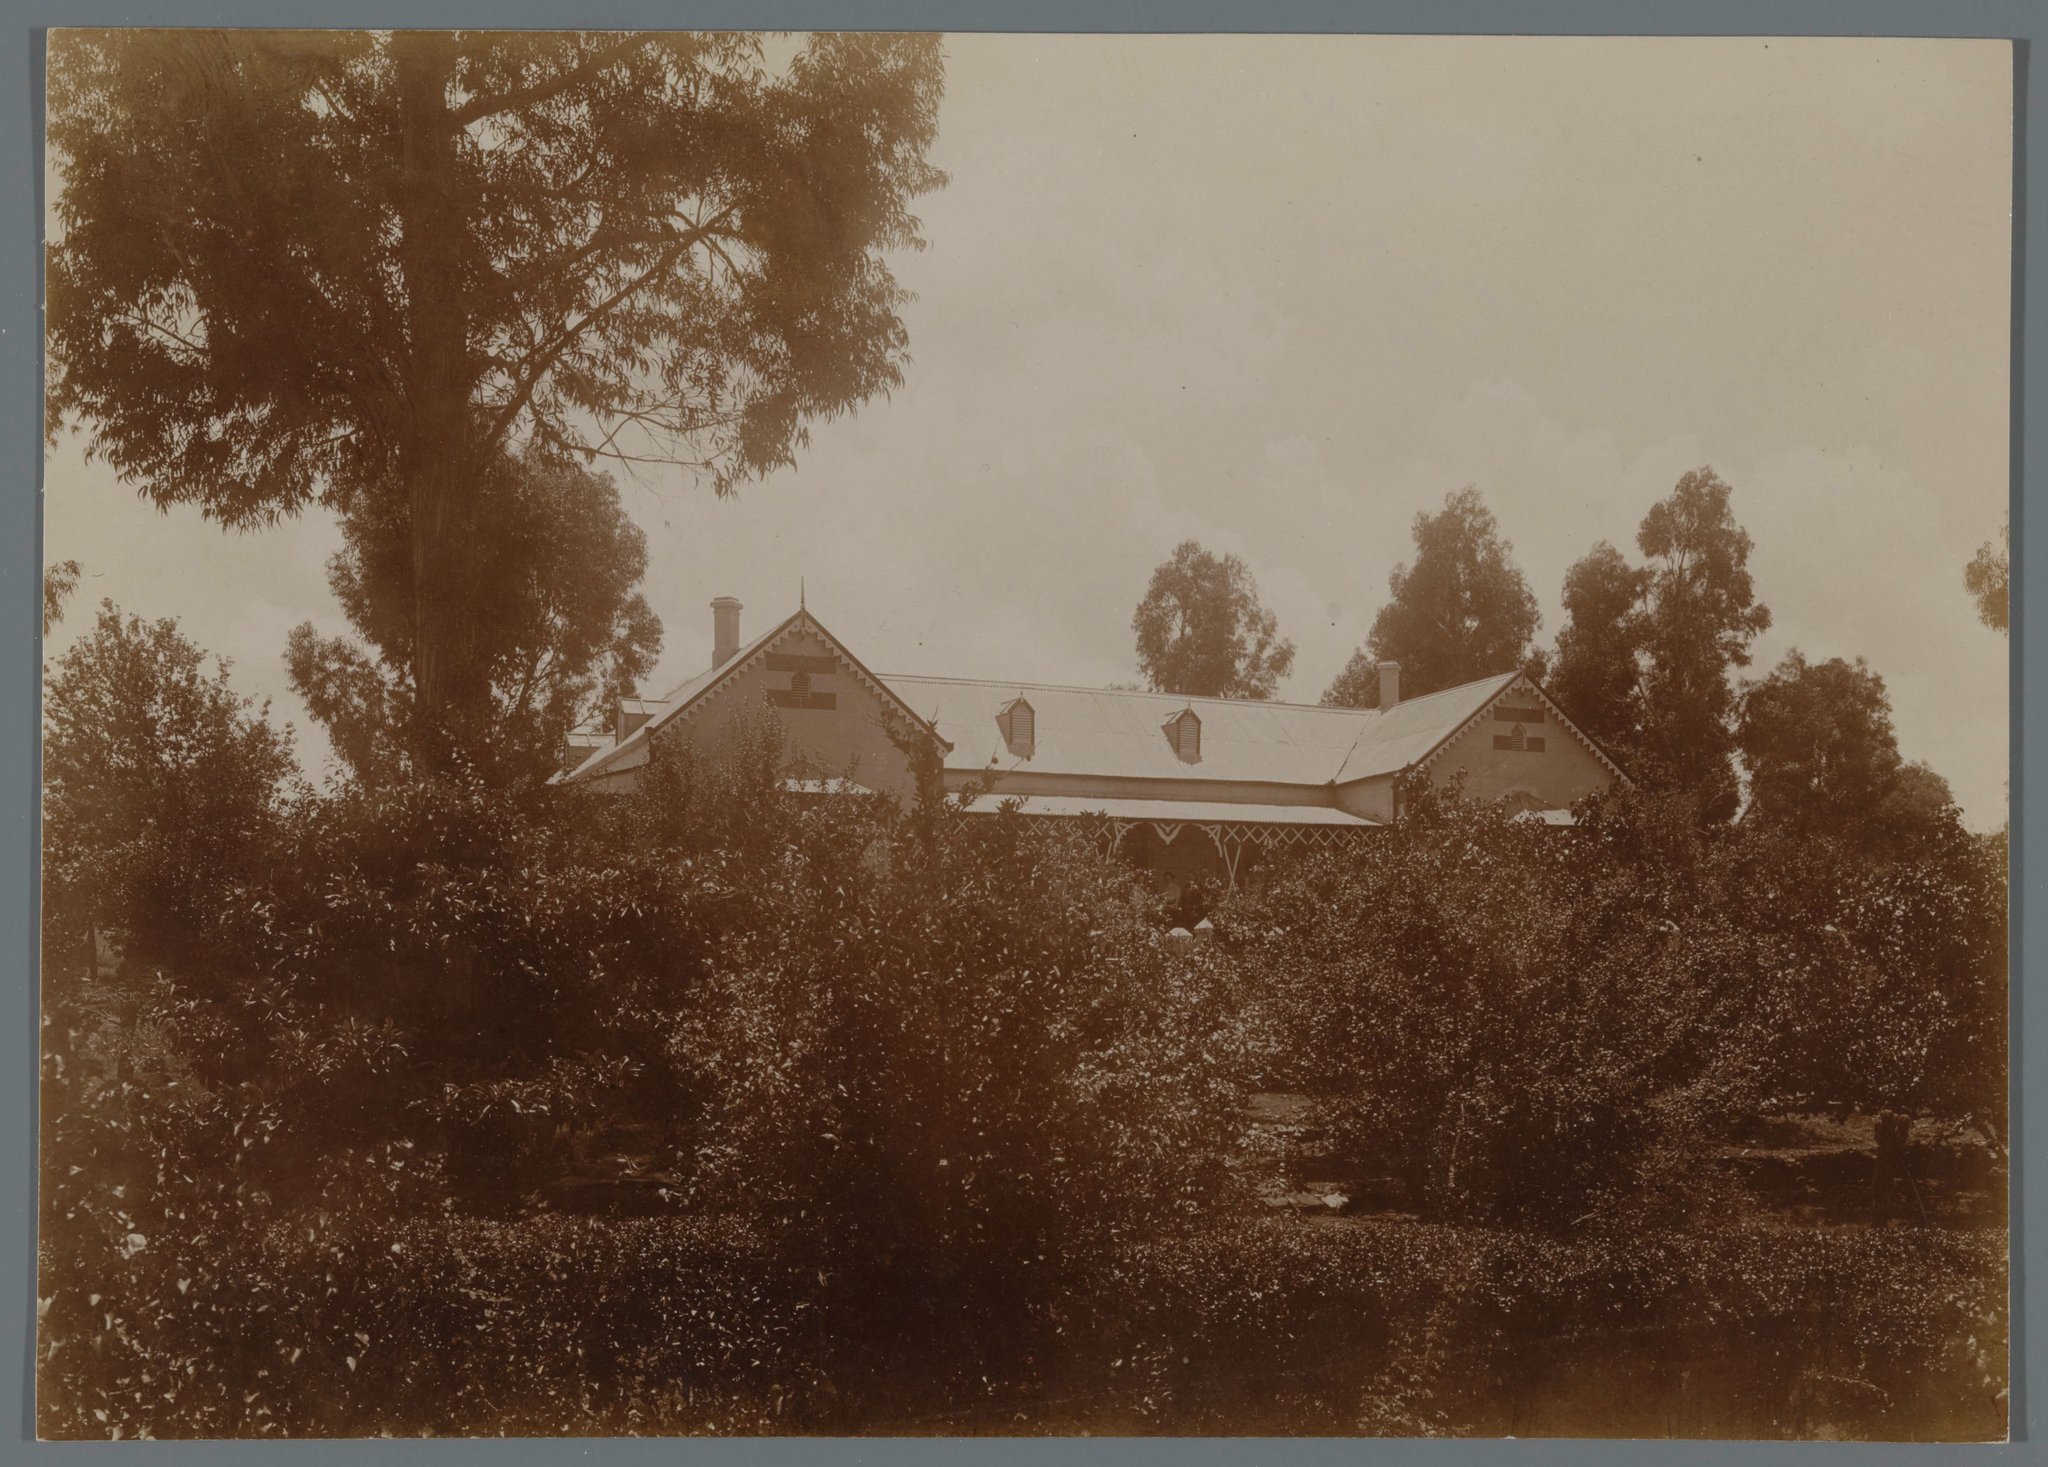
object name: photograph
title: Gezicht op een huis en tuin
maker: cornelia hendrika jonker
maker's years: 1874-1924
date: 1880-1920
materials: photographic support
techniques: collodion silver print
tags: garden, villa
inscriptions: annotation: ‘t'Huis van ons gezamen [Fockens]’